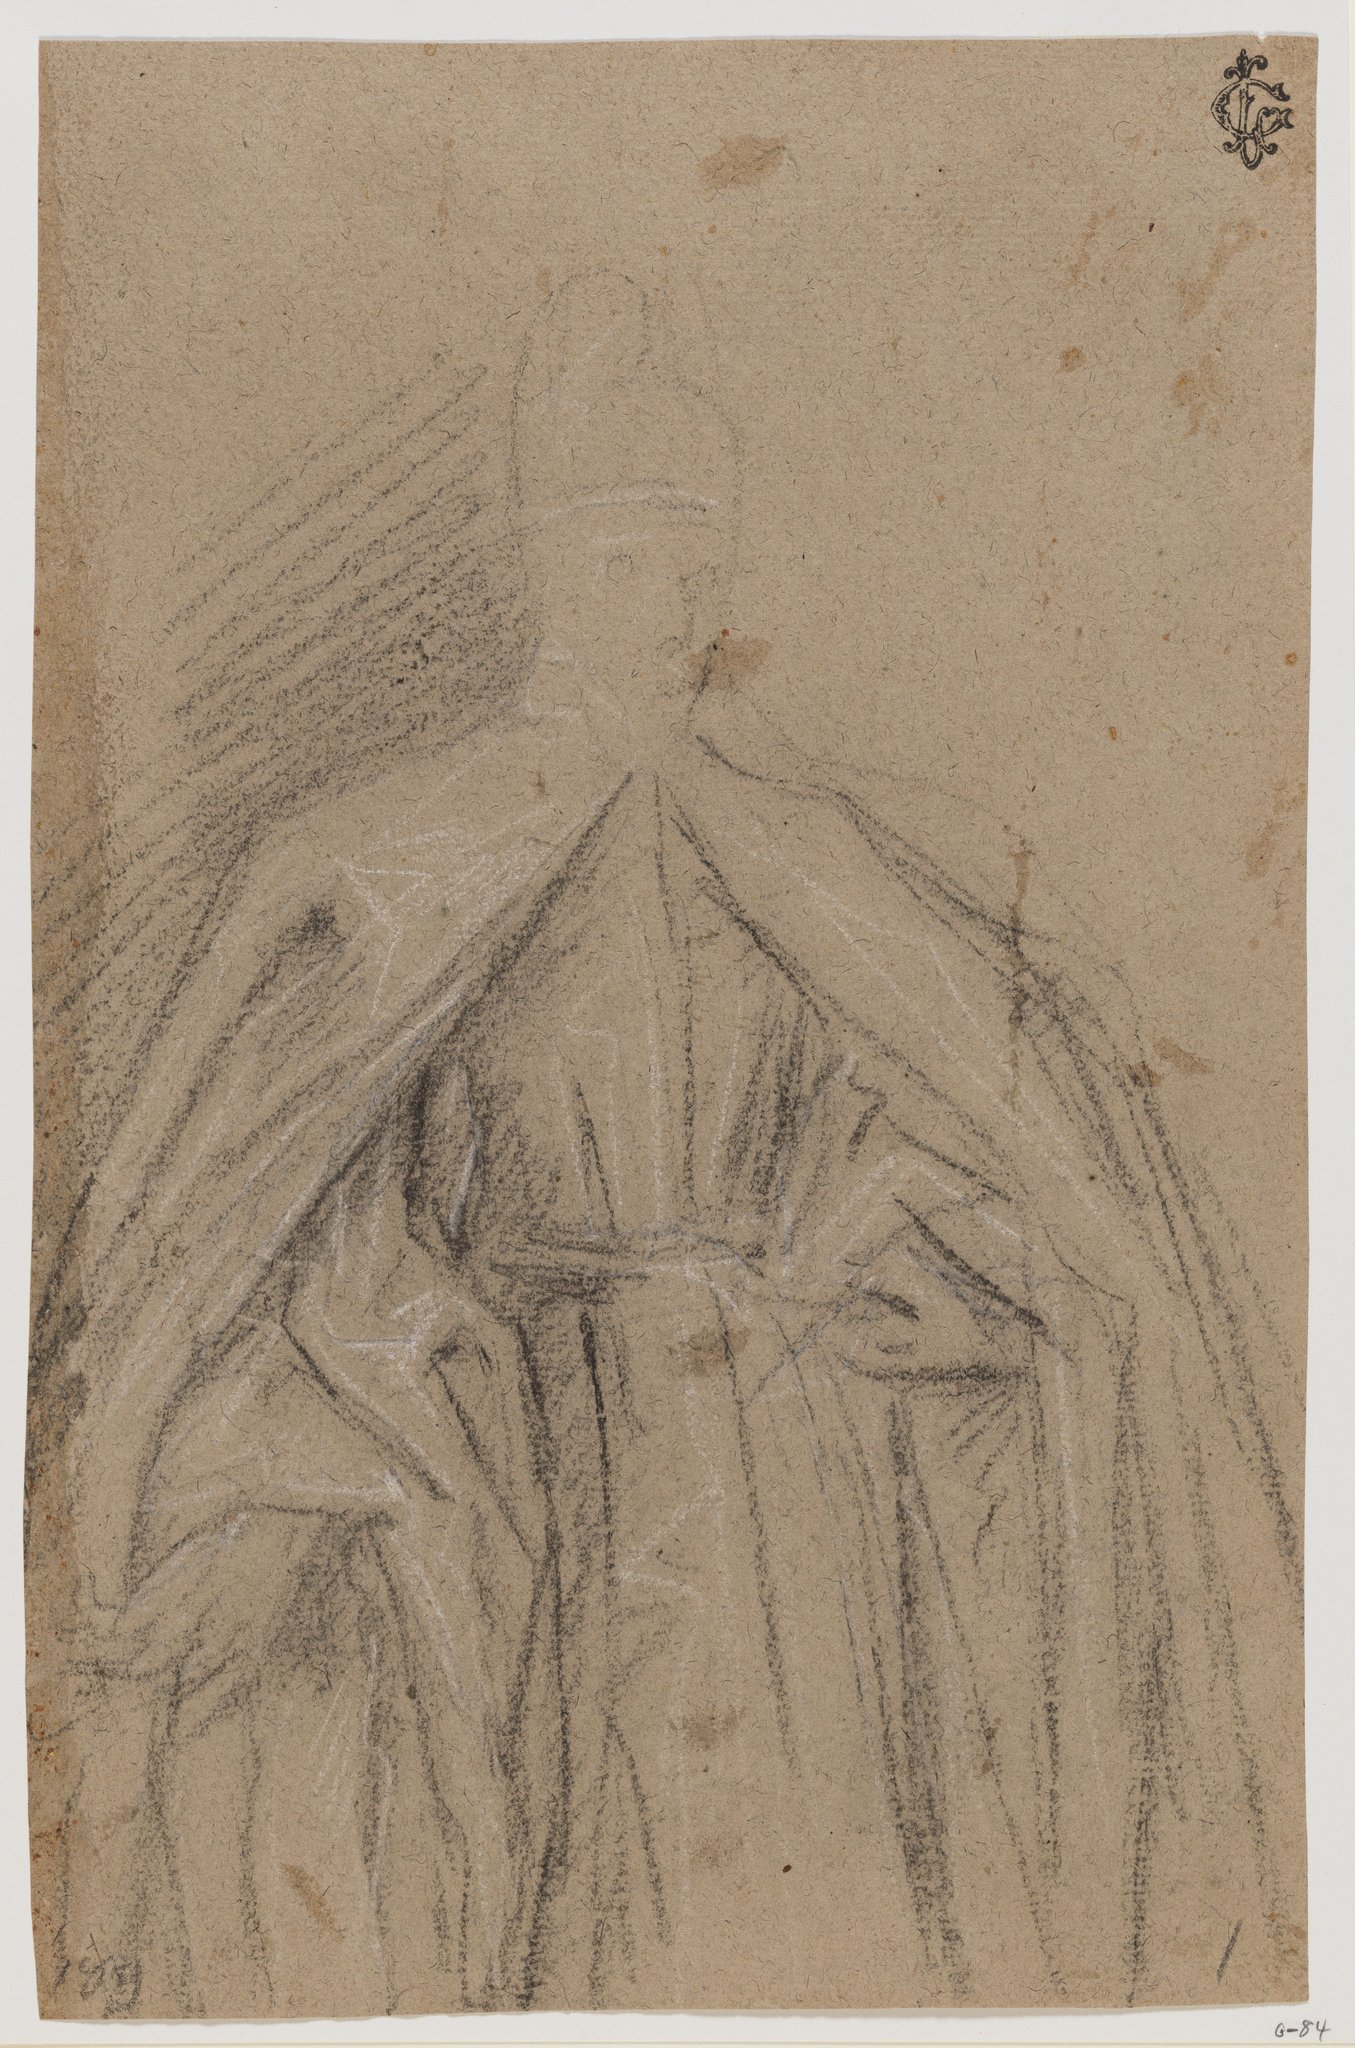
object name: drawing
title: Study for a Portrait of a Doge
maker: circle of tintoretto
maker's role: artist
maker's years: 1538-1594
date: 1576-1600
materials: chalk, paper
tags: men,portraits